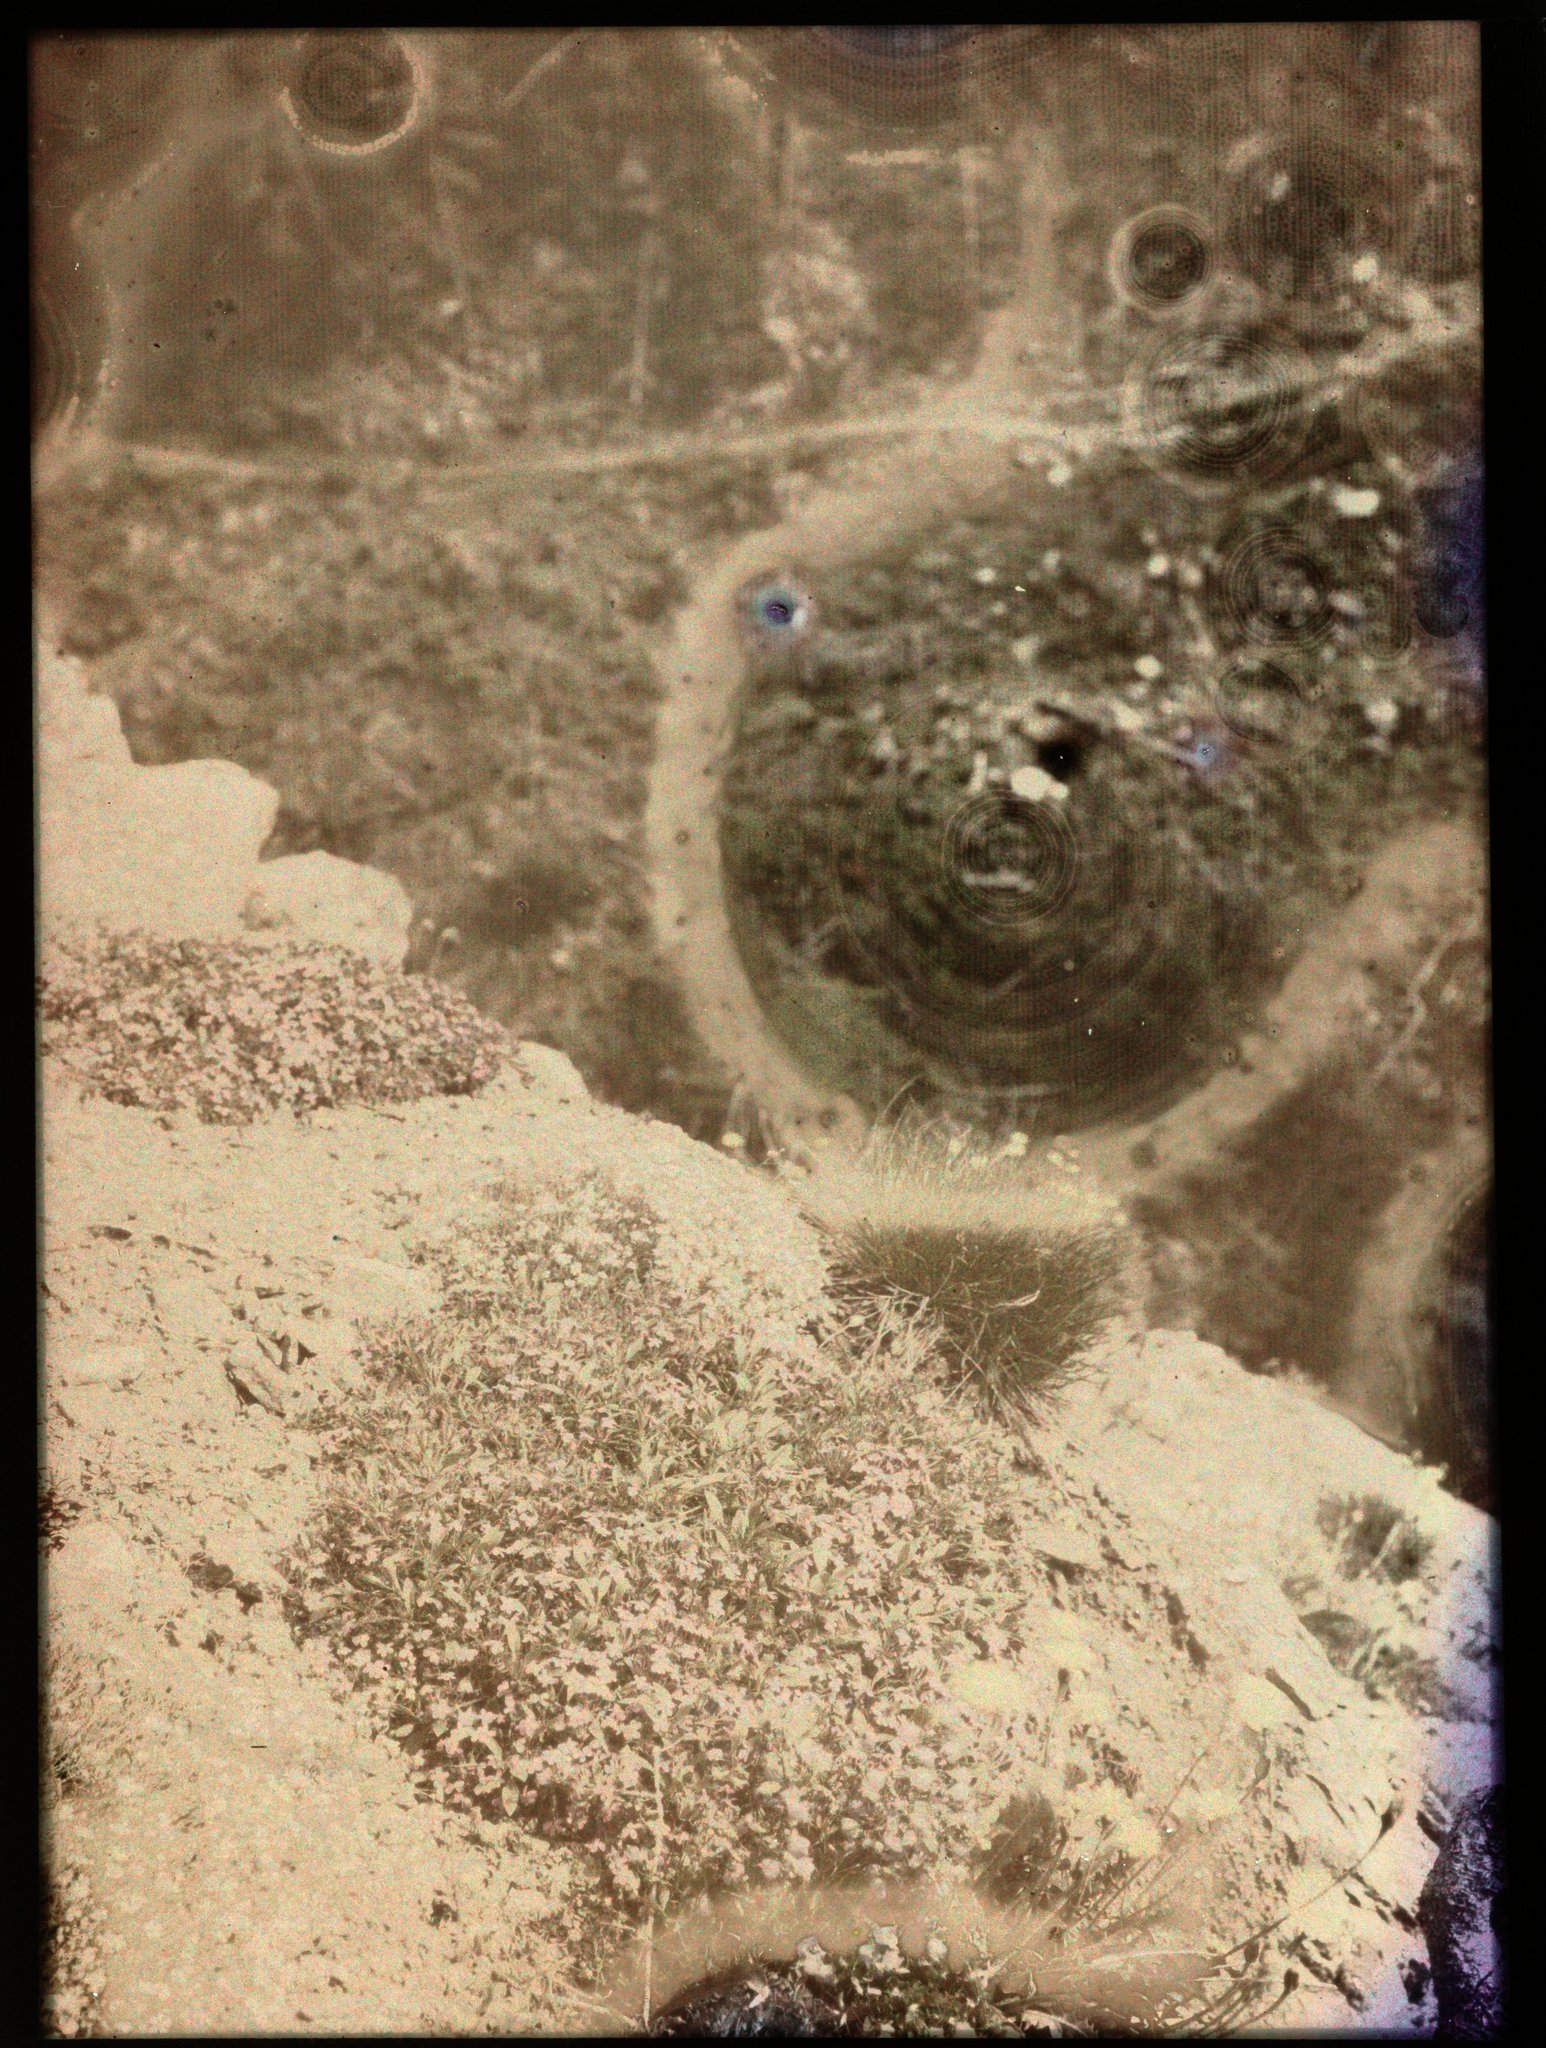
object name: color slide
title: Bloemen op steen-/rotsbodem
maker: adolphe burdet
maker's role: fotograaf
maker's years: 1860-1940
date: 1907-1930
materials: glass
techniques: autochrome process, slide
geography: netherlands